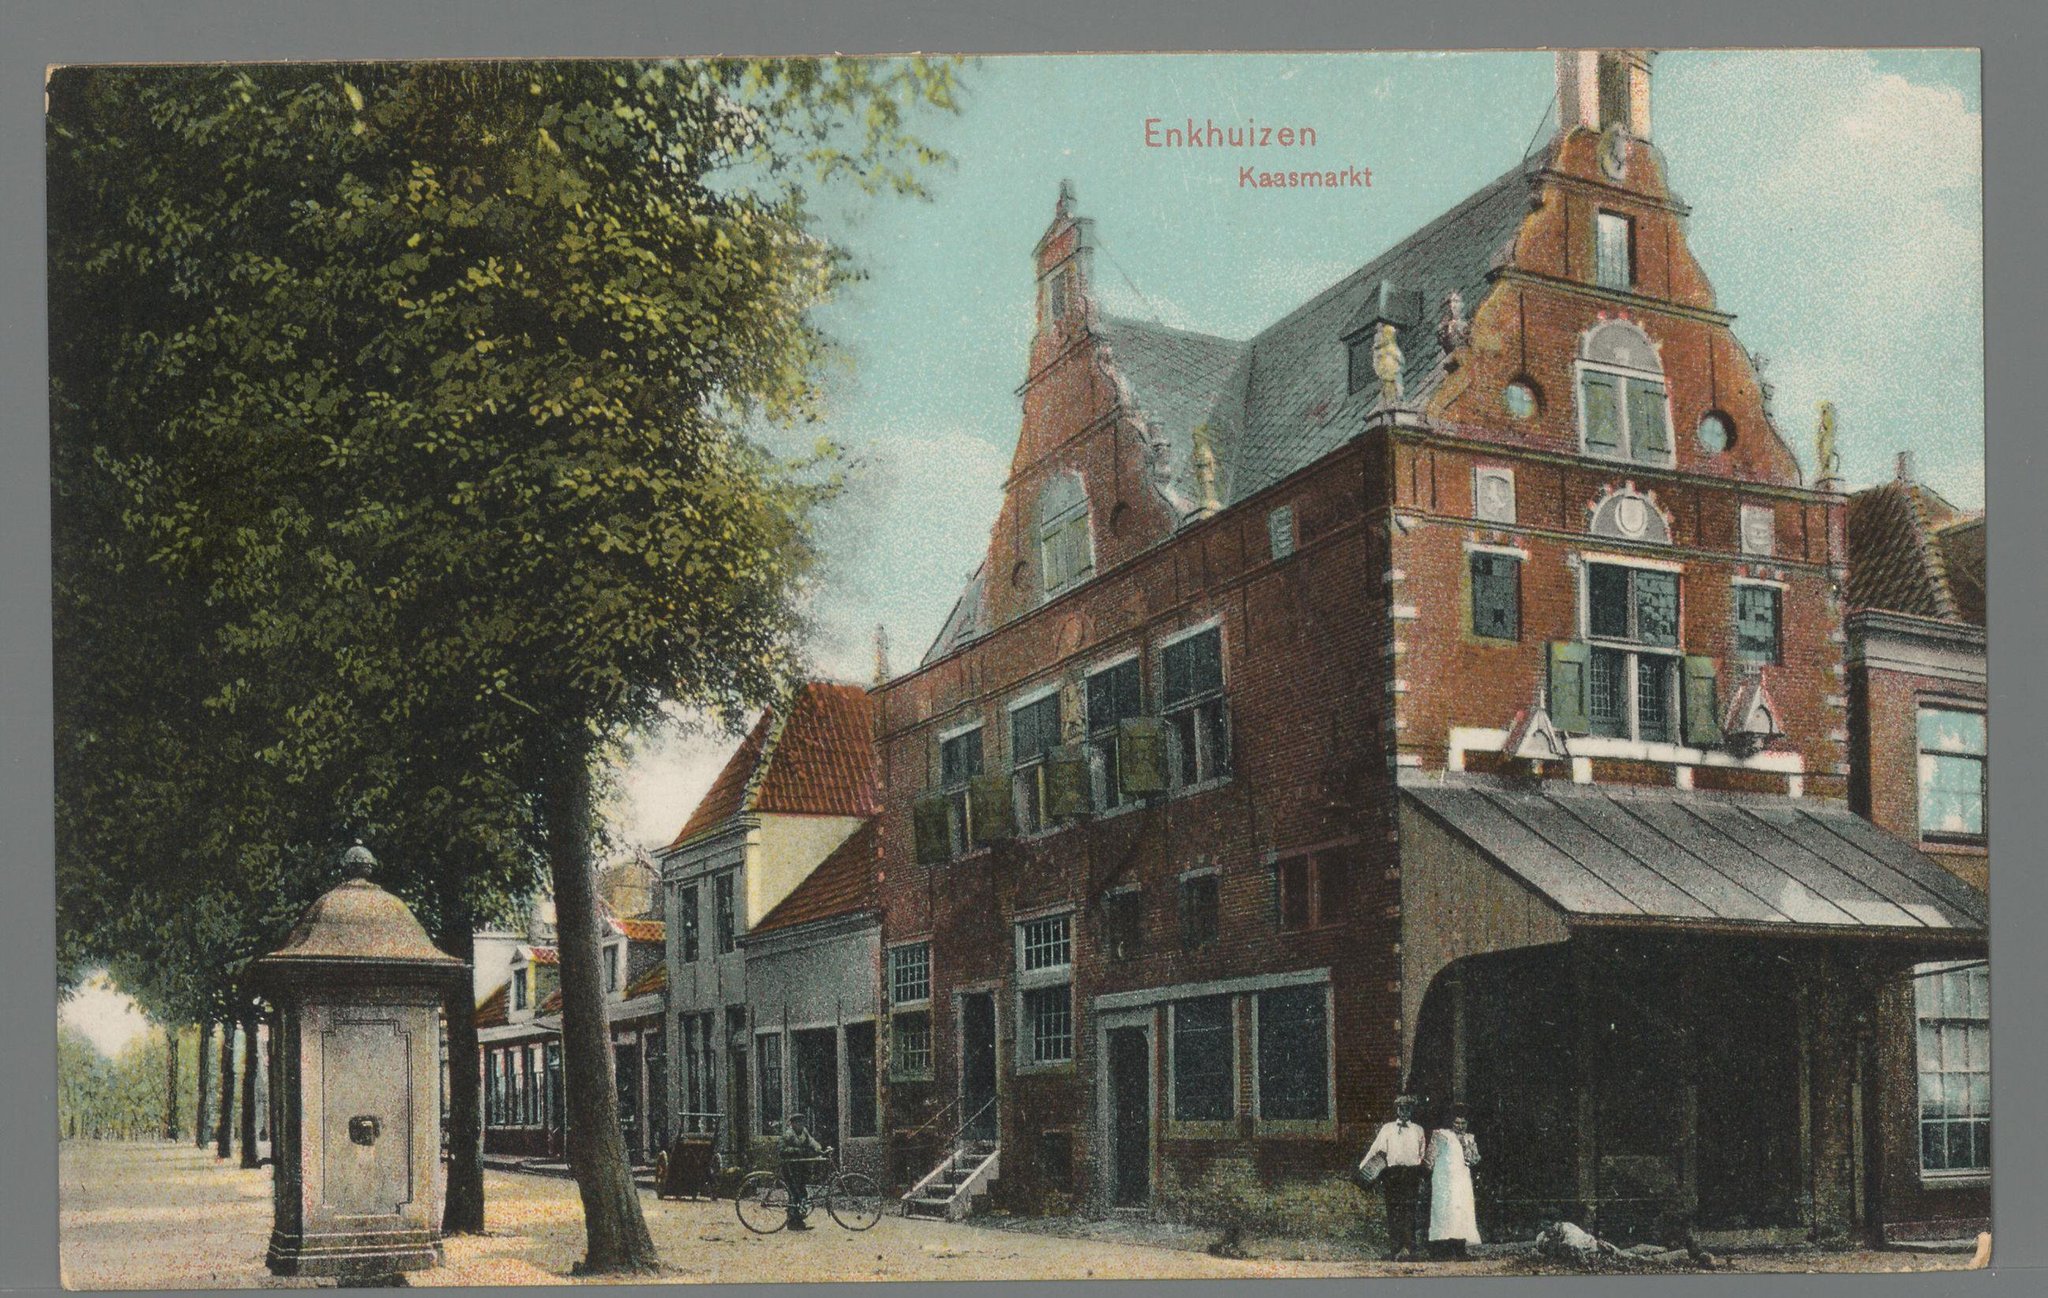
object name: photomechanical print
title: Enkhuizen. Kaasmarkt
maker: Anonymous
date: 1912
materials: cardboard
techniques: photograph, lithograph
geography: leipzig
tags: well, city-view, and landscape with man-made constructions, street, enkhuizen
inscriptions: date